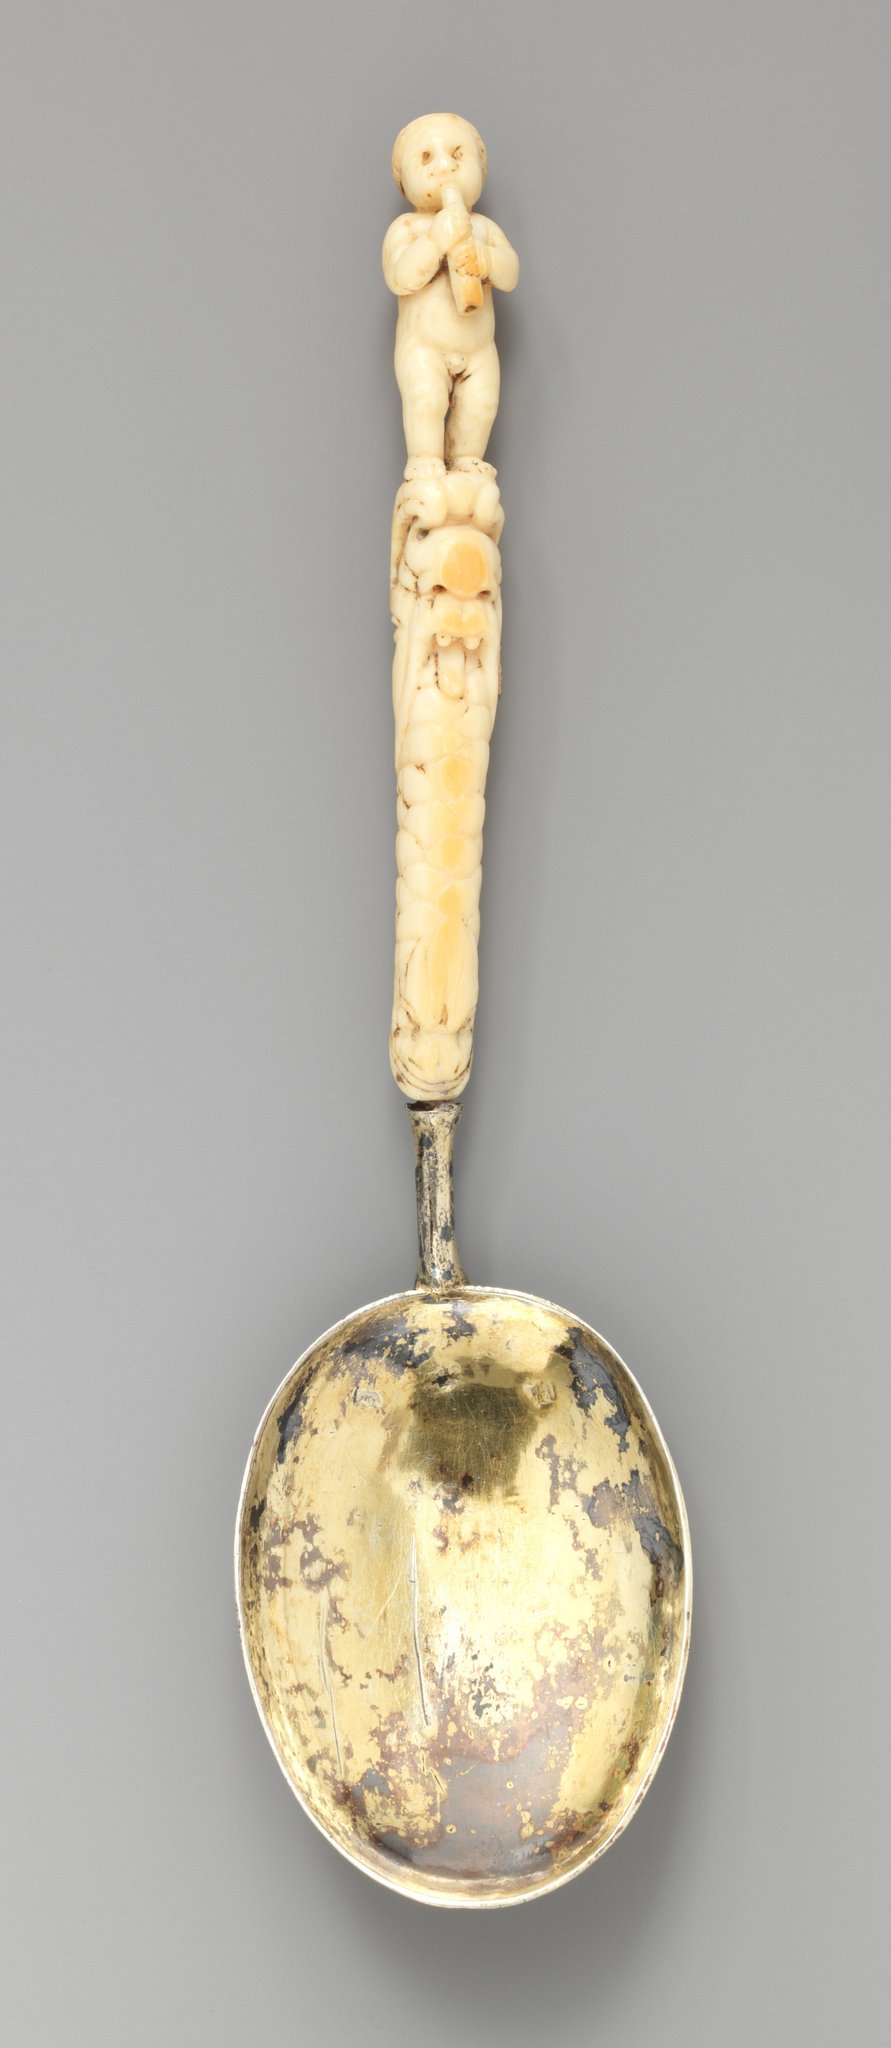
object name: spoon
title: Spoon with handle carved with putto playing a pipe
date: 1744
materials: ivory, silver gilt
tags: putti